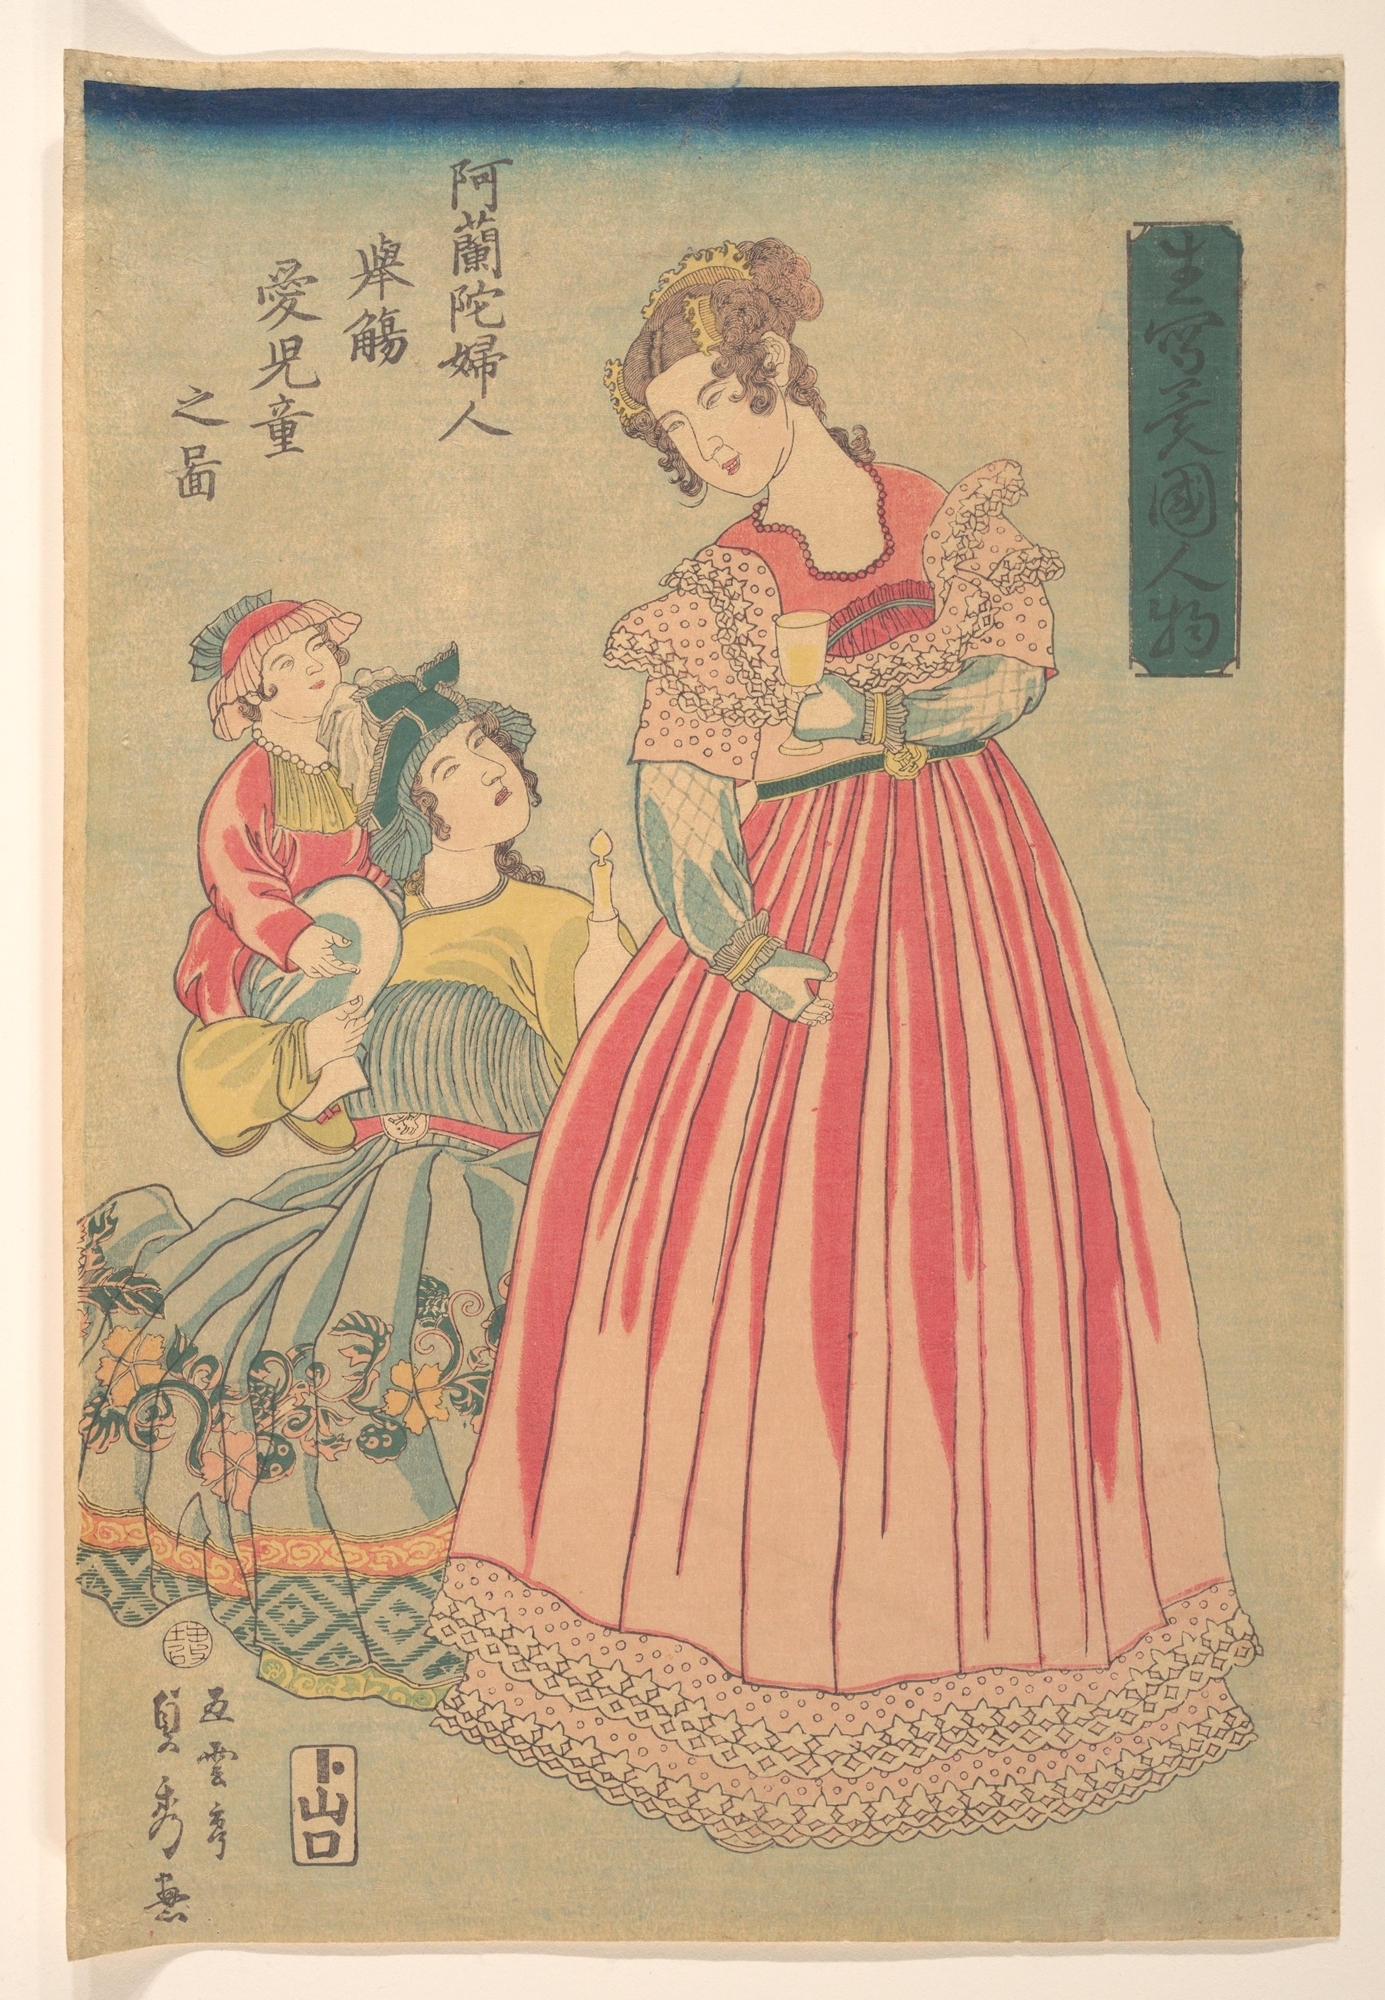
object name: print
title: Dutch Woman and Child (Seisha ikoku jinbutsu Oranda fujin aijidō no zu)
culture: japanese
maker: utagawa (gountei) sadahide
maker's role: artist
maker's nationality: japanese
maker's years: 1807-1873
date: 1860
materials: ink, paper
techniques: nishiki e, woodblock print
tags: children,women